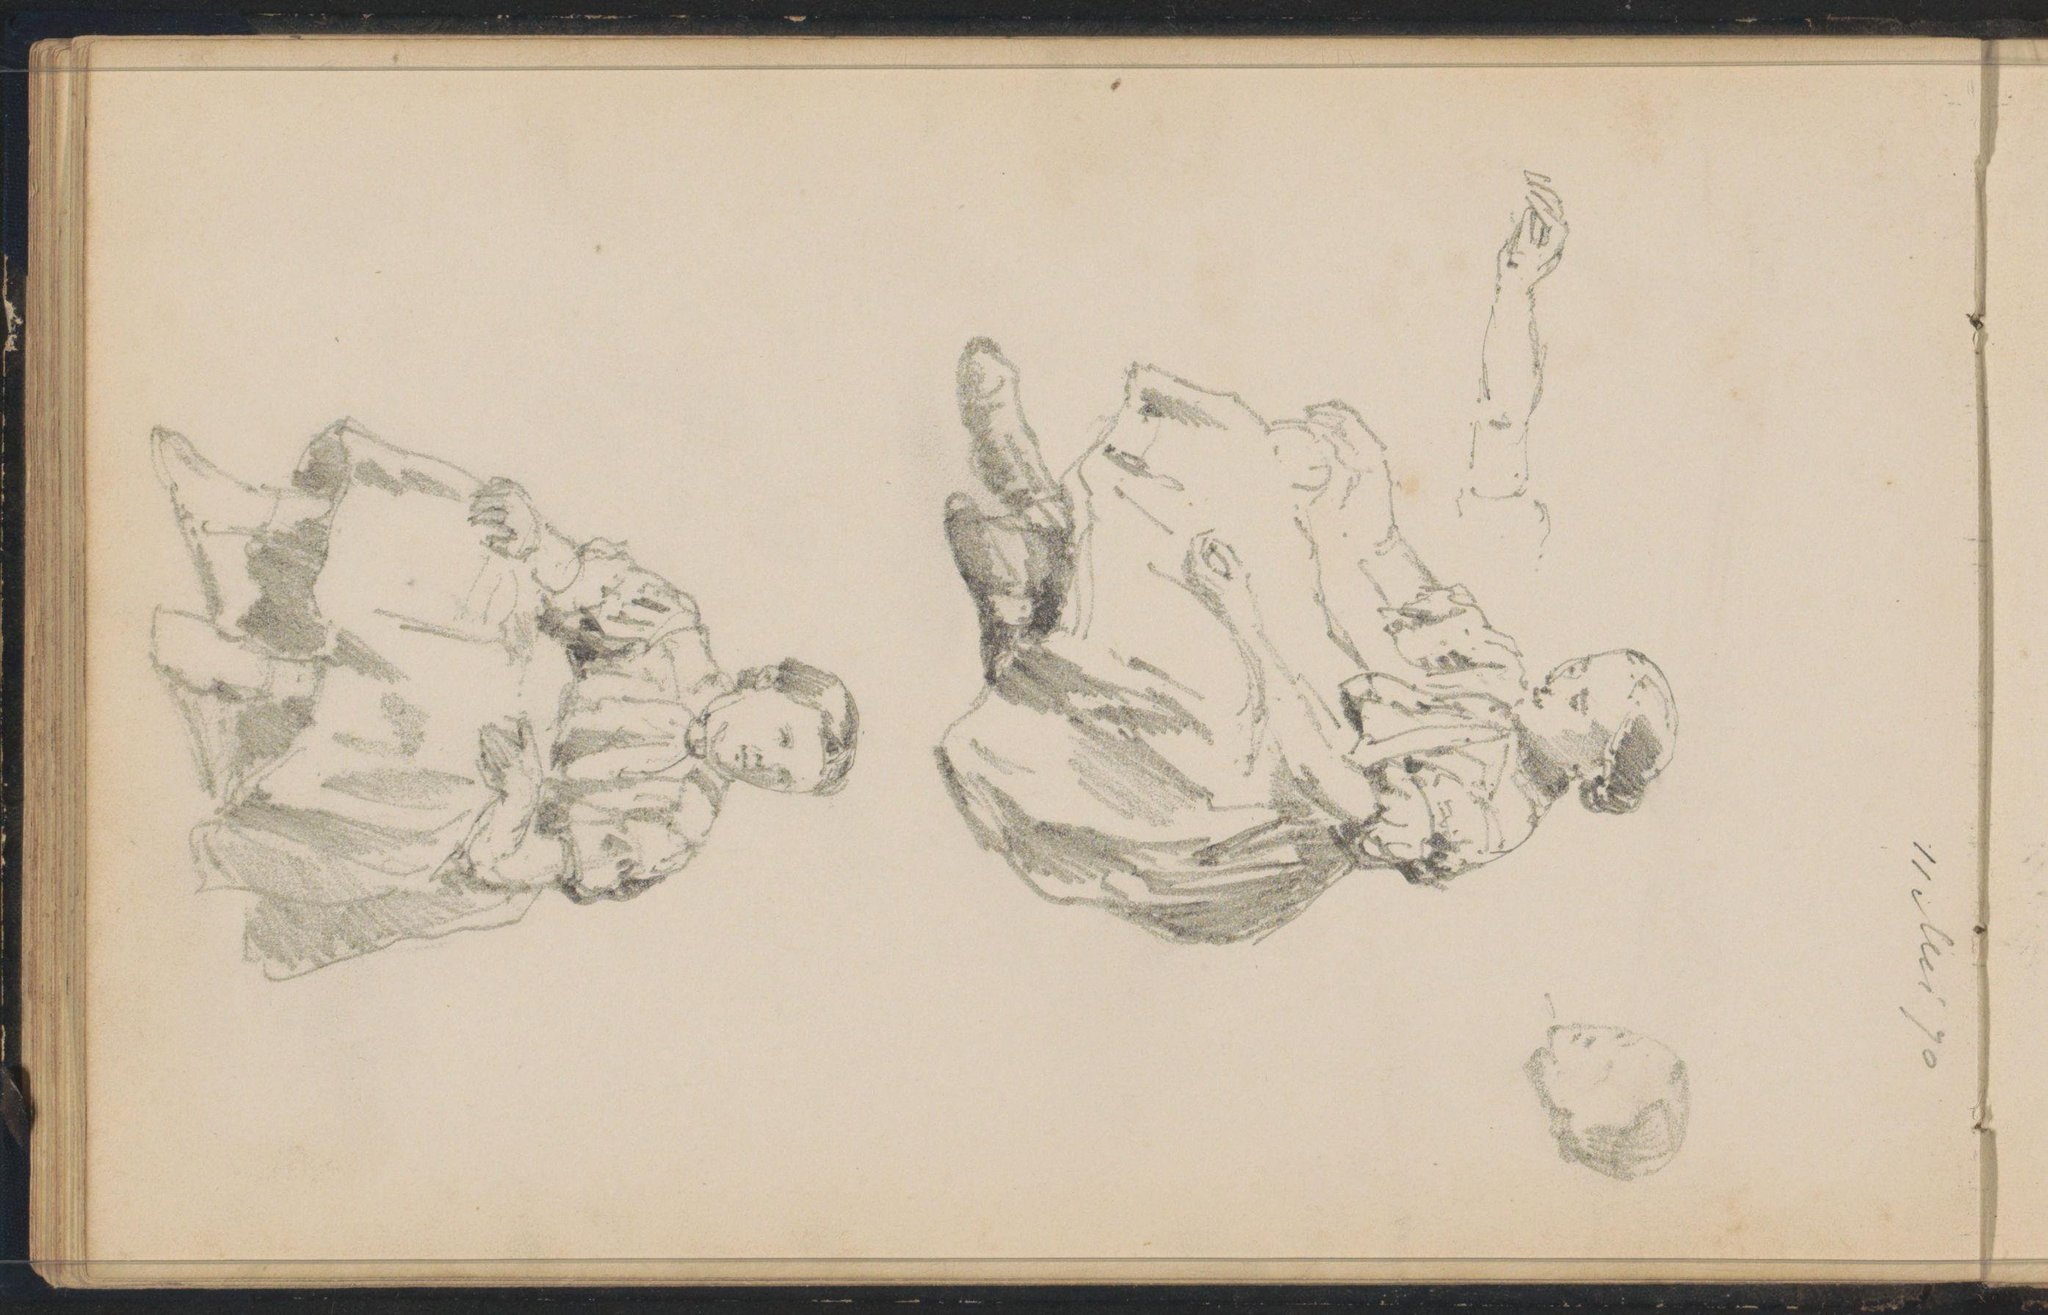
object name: sketchbook leaf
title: Studieblad met jonge vrouwen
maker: cornelis springer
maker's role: draughtsman, painter, print maker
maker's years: 1817-1891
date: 1870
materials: paper, pencil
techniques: stumping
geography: netherlands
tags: sitting figure - aa - female human figure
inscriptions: date: ‘11 Mei 70’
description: Twee zittende, jonge vrouwen. Linksboven een studie van een arm en rechtsboven een vrouwenhoofd. Blad 15 verso uit een schetsboek met 40 bladen, vervaardigd in Woerden en Gouda.